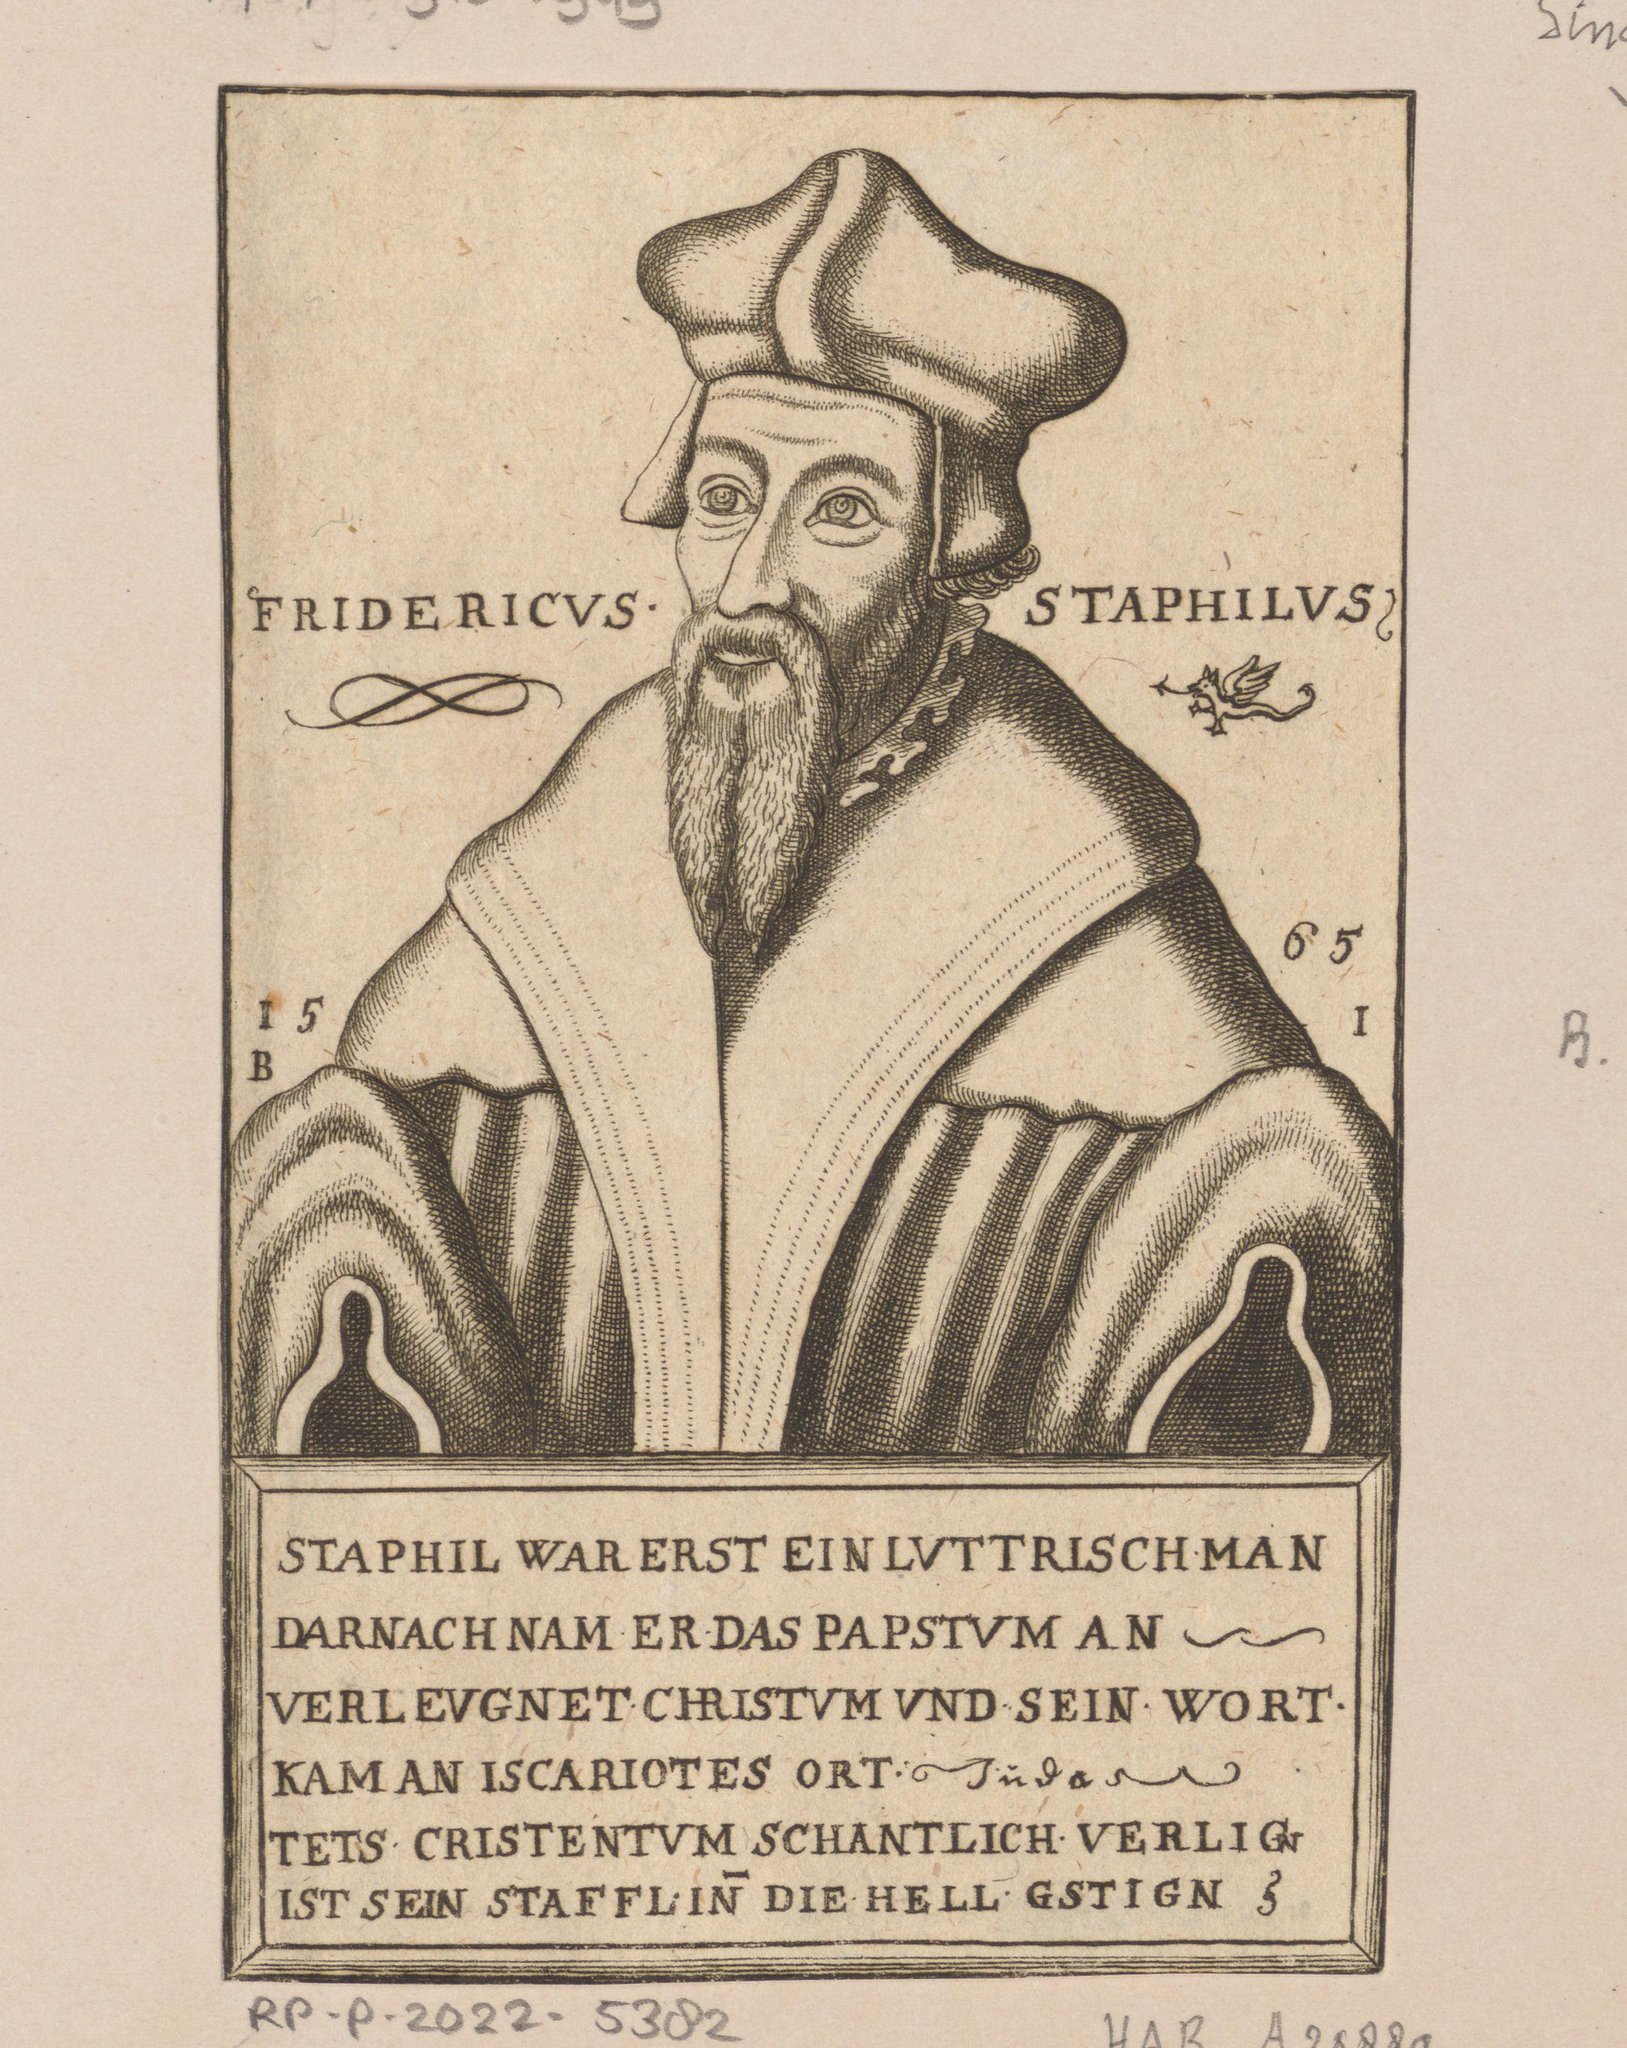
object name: print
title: Portret van Friedrich Stapellage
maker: balthasar jenichen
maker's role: draughtsman, goldsmith, print maker, printer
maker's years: -1621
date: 1563-1592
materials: paper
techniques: etching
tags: theologian, historical persons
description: Met zesregelig onderschrift in het Duits.